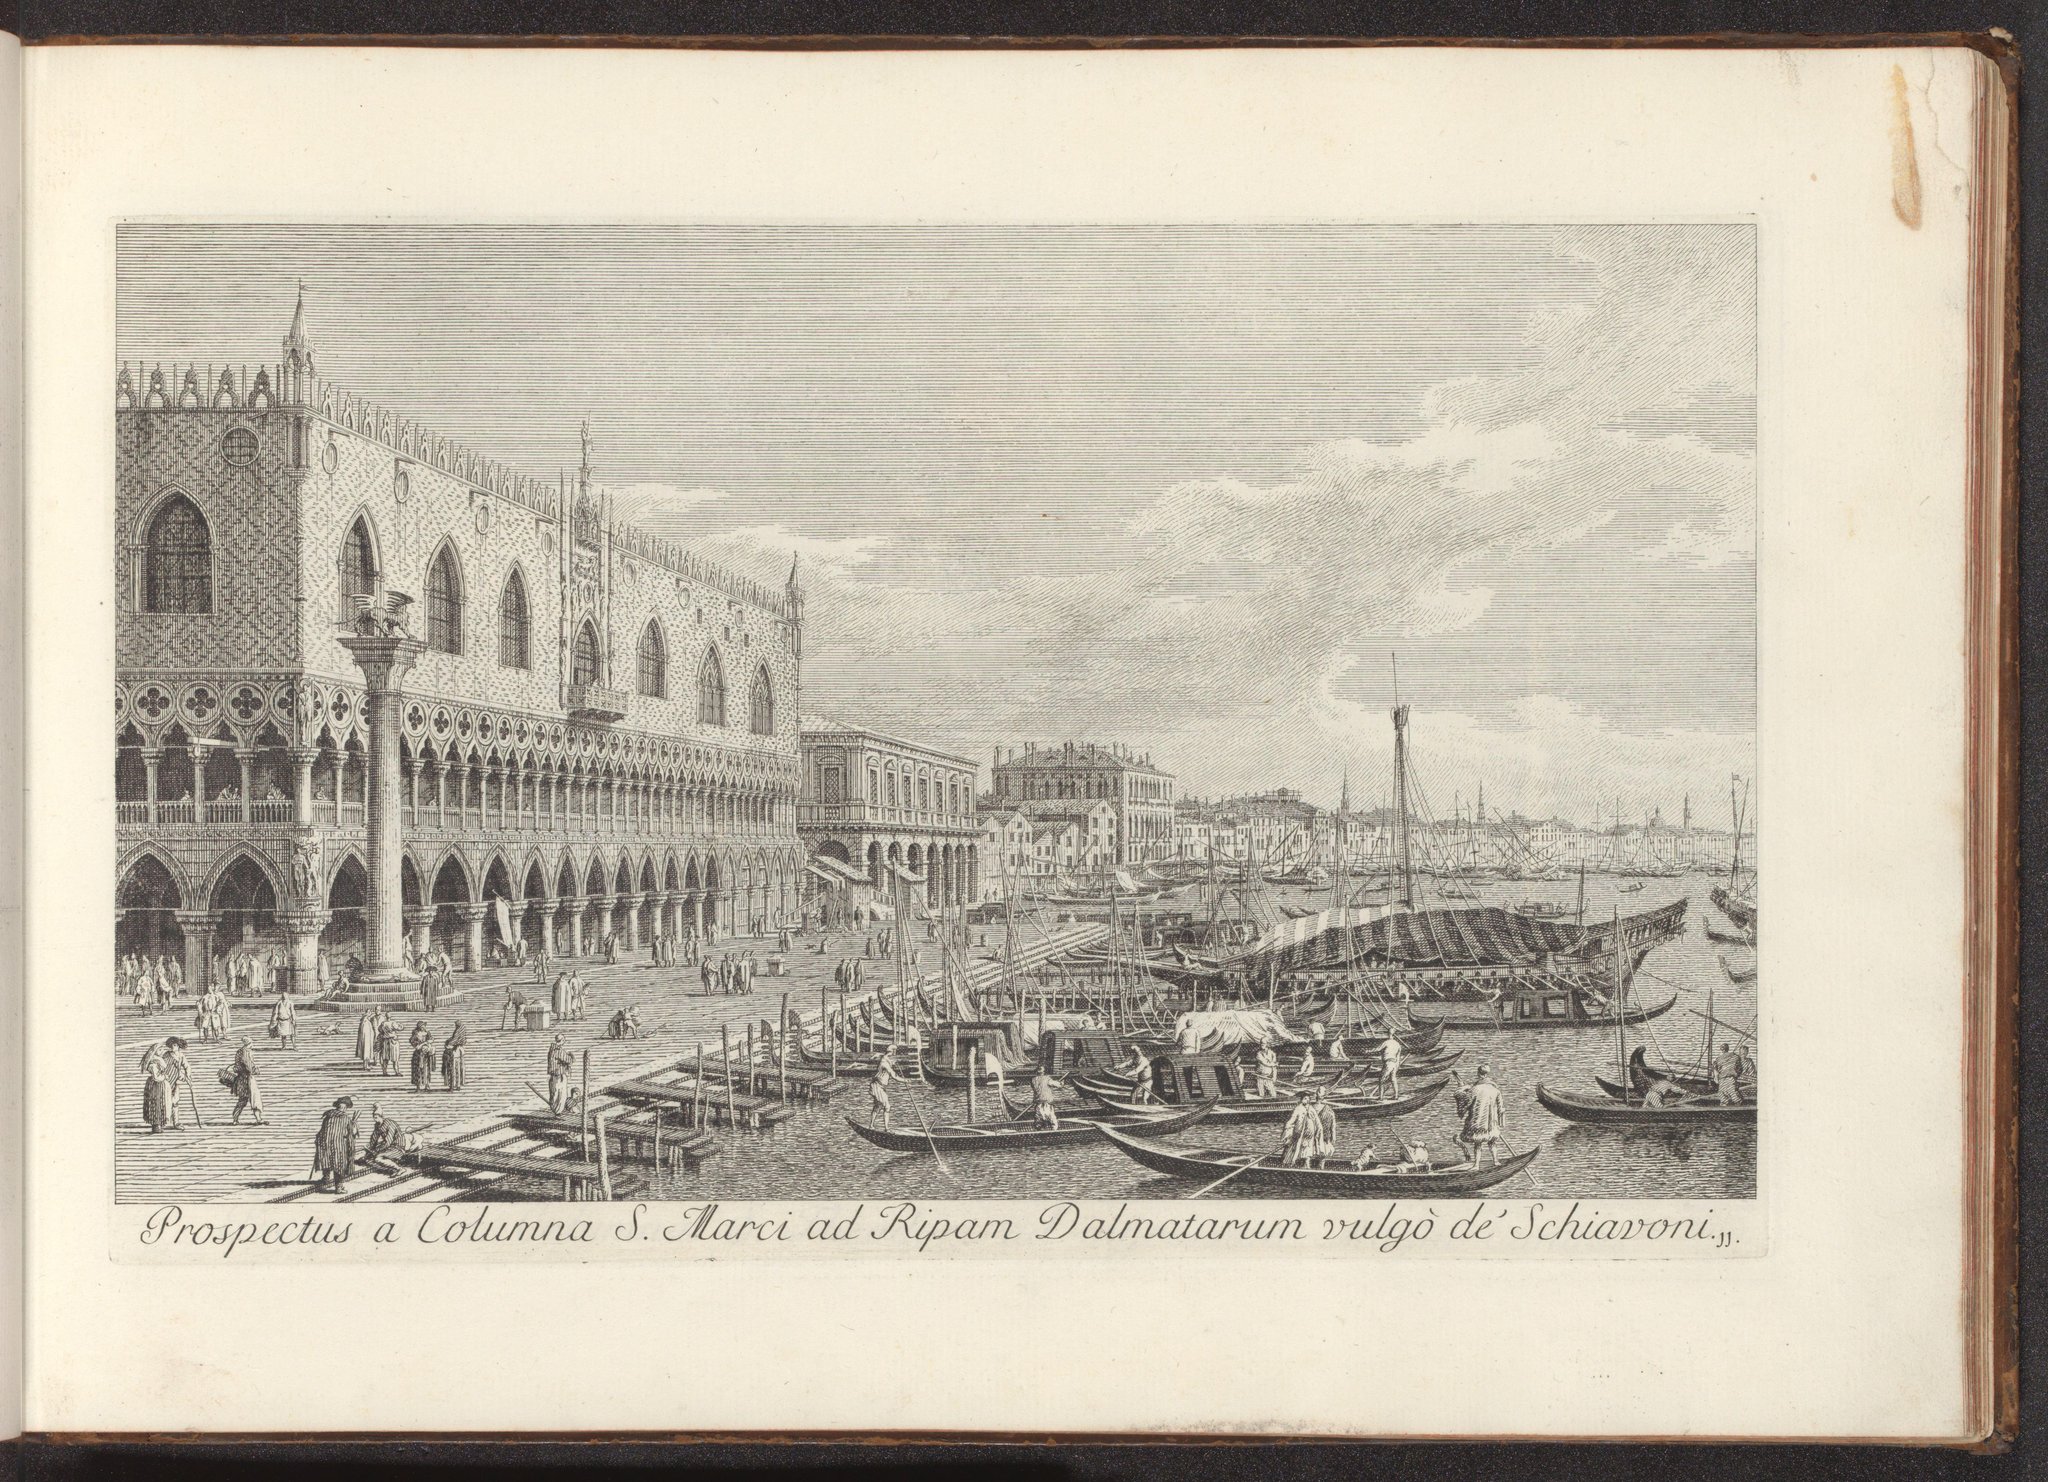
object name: print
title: Gezichten op grote kanalen in Venetië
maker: antonio visentini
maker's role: draughtsman, print maker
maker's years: 1688-1782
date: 1742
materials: paper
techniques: etching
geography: venice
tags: square, place, circus, etc., city-view, and landscape with man-made constructions, canal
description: Gezicht op de hoek van het San Marcoplein met het Dogepaleis en de zuil met de Leeuw van Venetië. Op deze hoek kruisen het San Marcoplein en de Riva degli Schiavone elkaar. De prent maakt deel uit van een album.